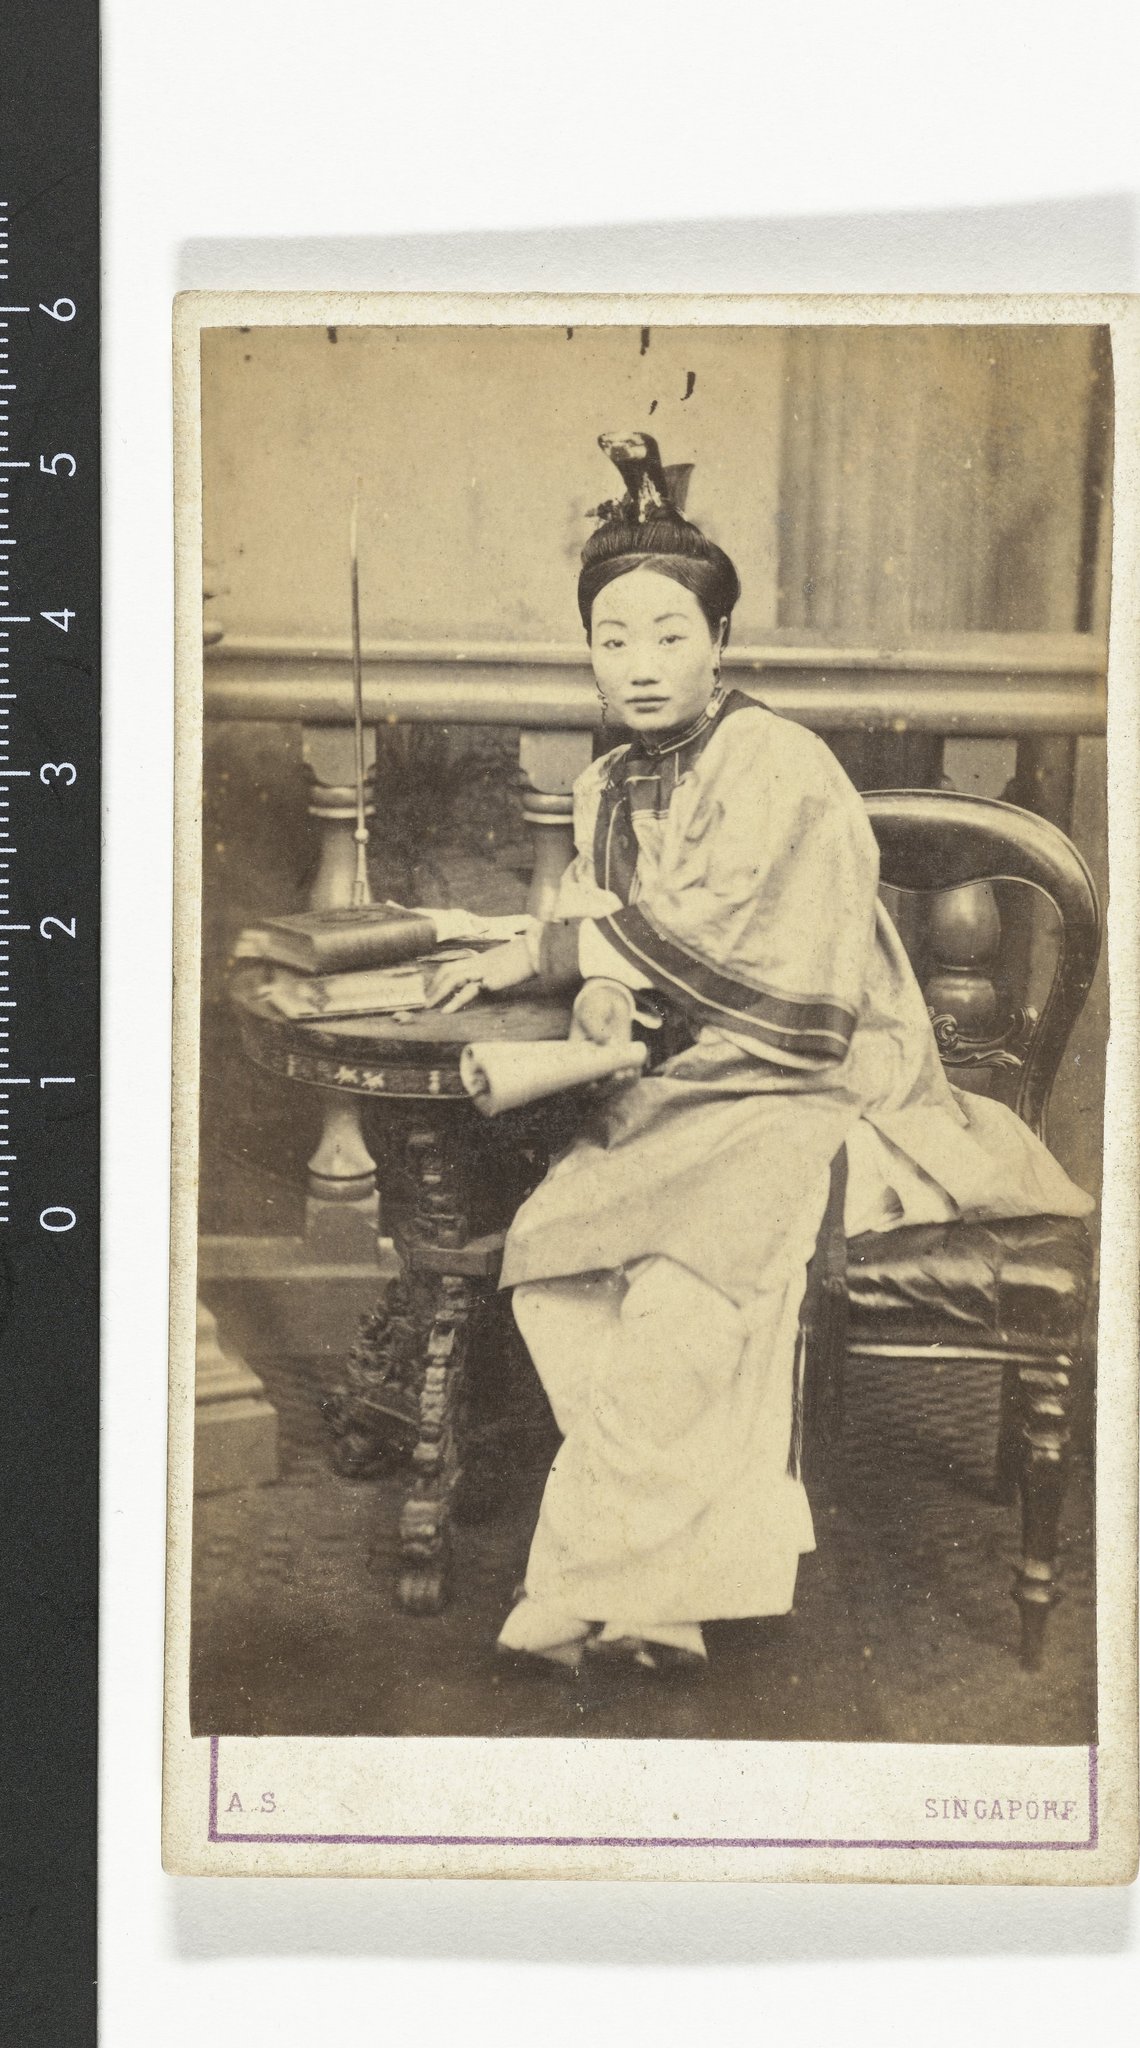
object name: carte de visite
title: Chineesche meid Chinatown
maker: august sachtler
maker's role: fotograaf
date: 1870-1900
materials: cardboard, paper, photographic support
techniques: albumen print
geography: singapore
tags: historical persons not known by name - bb - woman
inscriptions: signature: ‘A.S Singapore’, title: ‘Chineesche meid Chinatown’